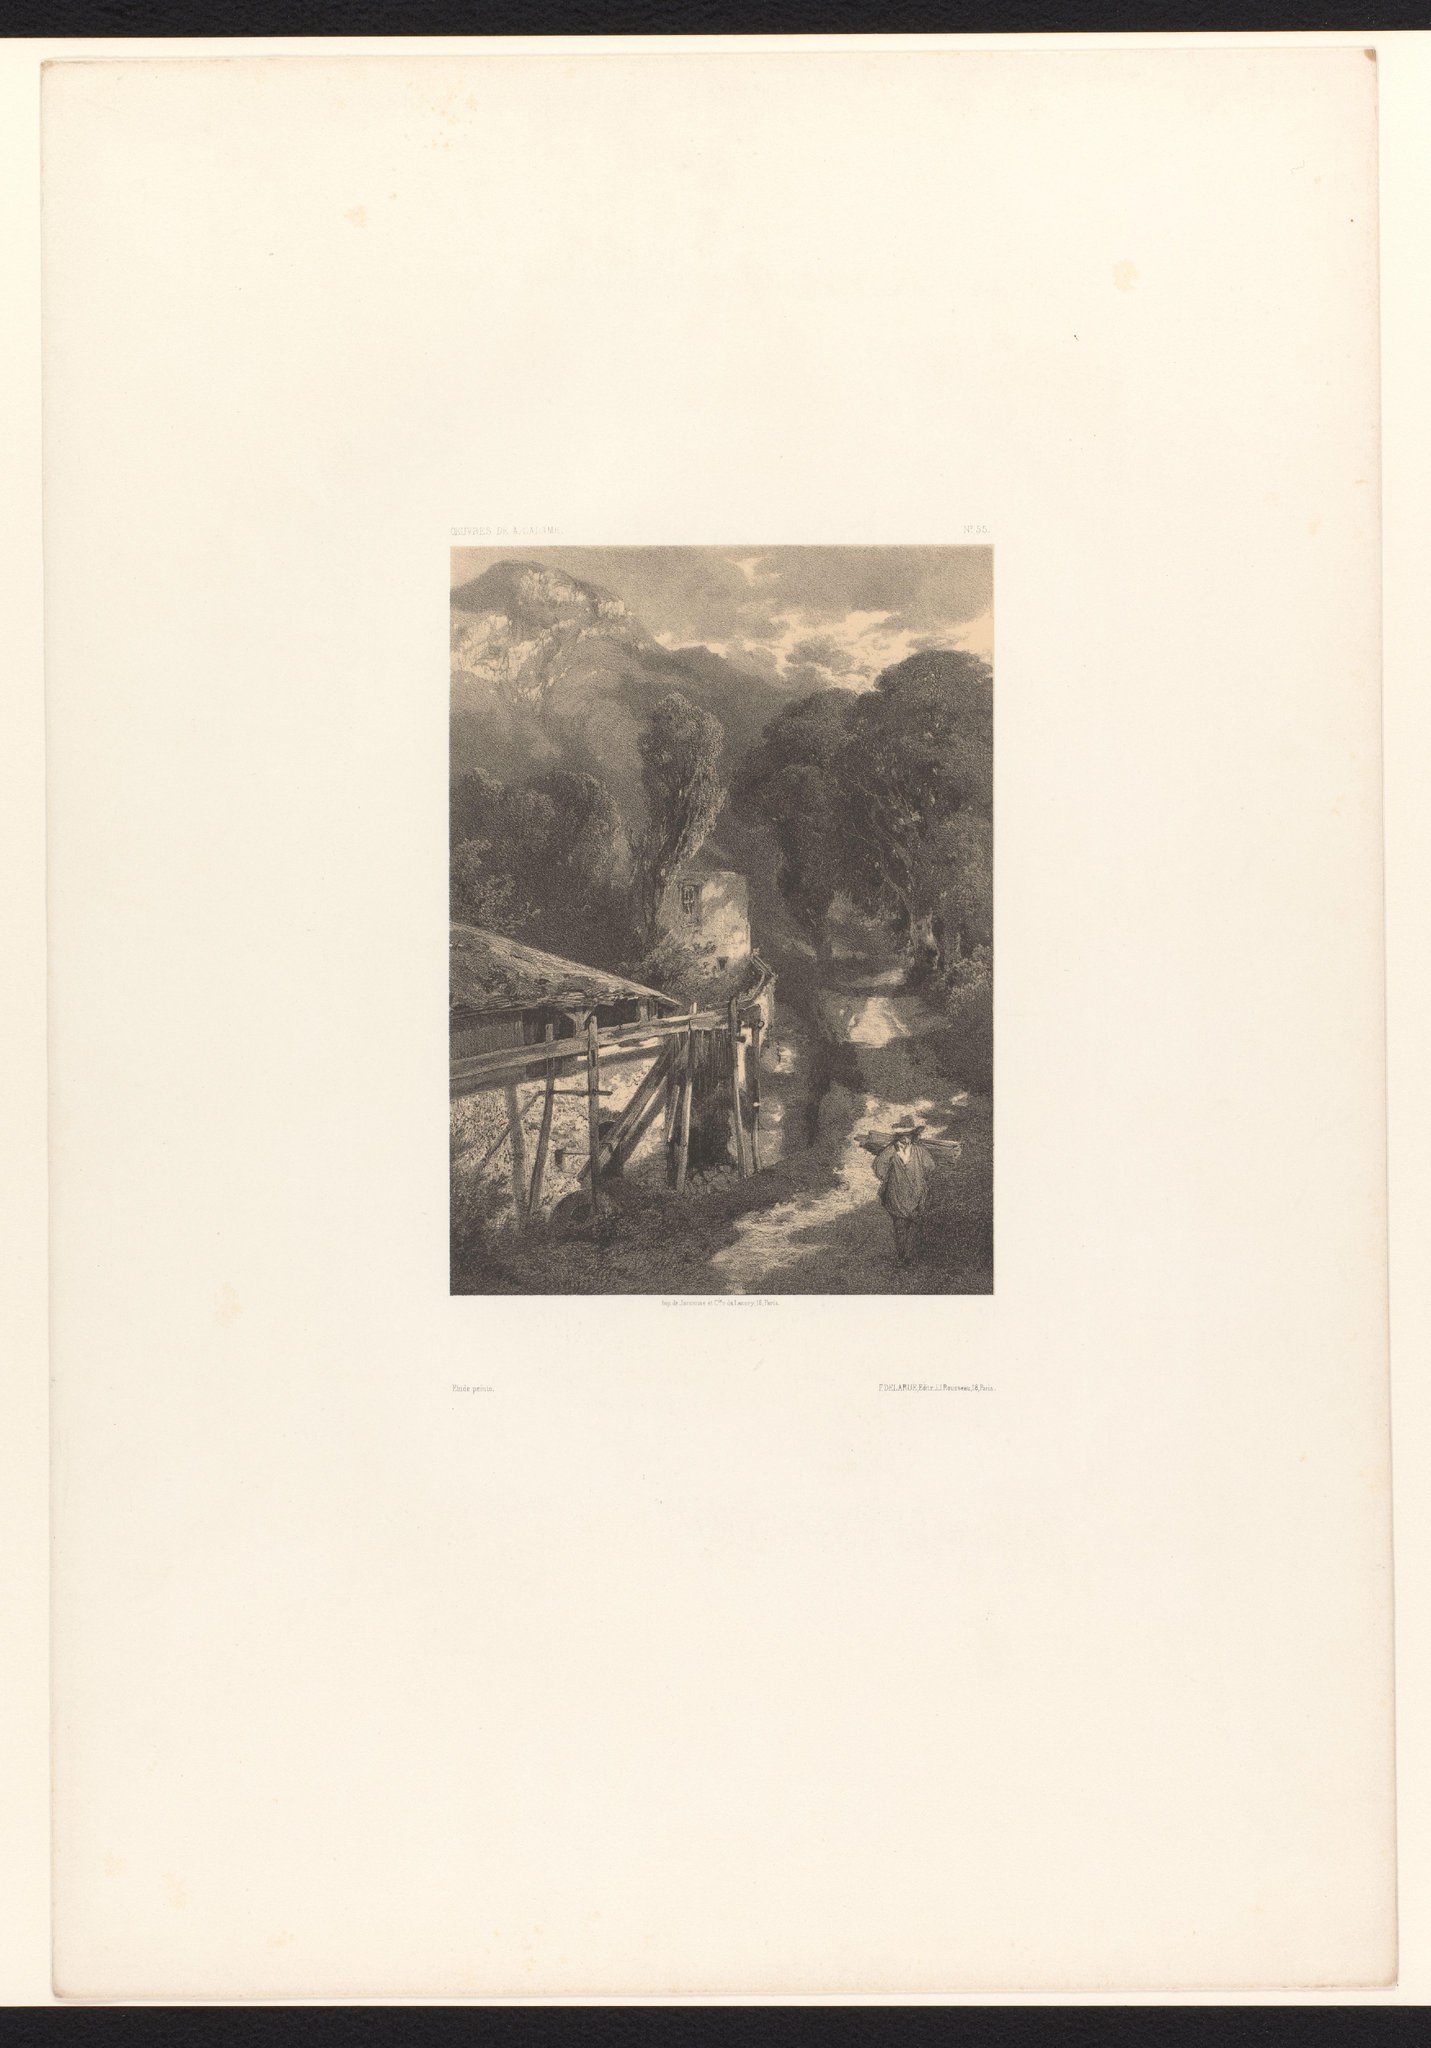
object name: print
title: Oeuvres de A. Calame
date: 1852-1855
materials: paper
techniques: lithograph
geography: paris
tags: rural housing, e.g. country-house, villa, cottage, road, path, mountains (+ landscape with figures, staffage)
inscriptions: collector's mark: Lugt 2228a